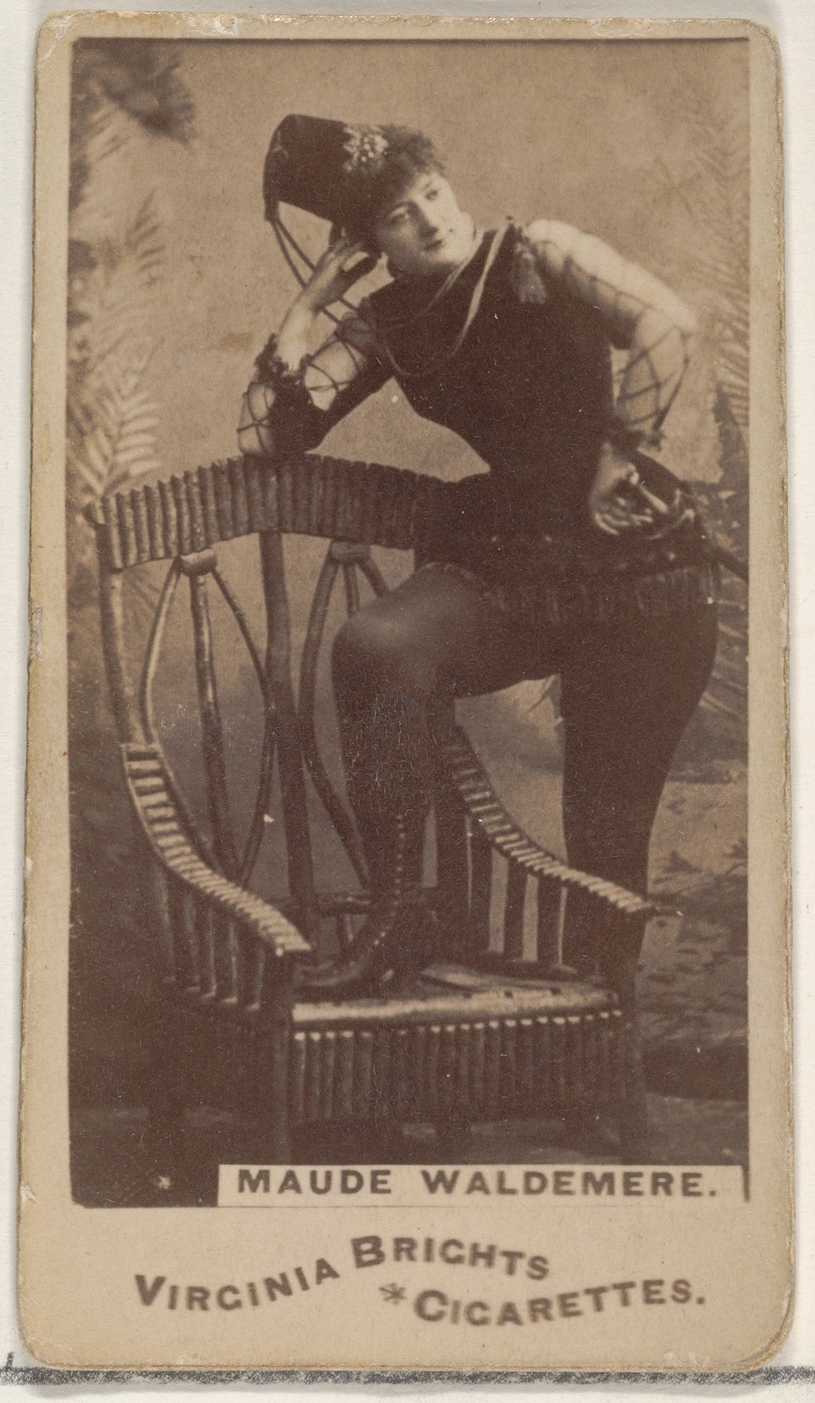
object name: photograph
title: Maude Waldemere, from the Actors and Actresses series (N45, Type 1) for Virginia Brights Cigarettes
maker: allen & ginter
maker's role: publisher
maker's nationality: american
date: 1888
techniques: albumen silver print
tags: portraits,women,actresses